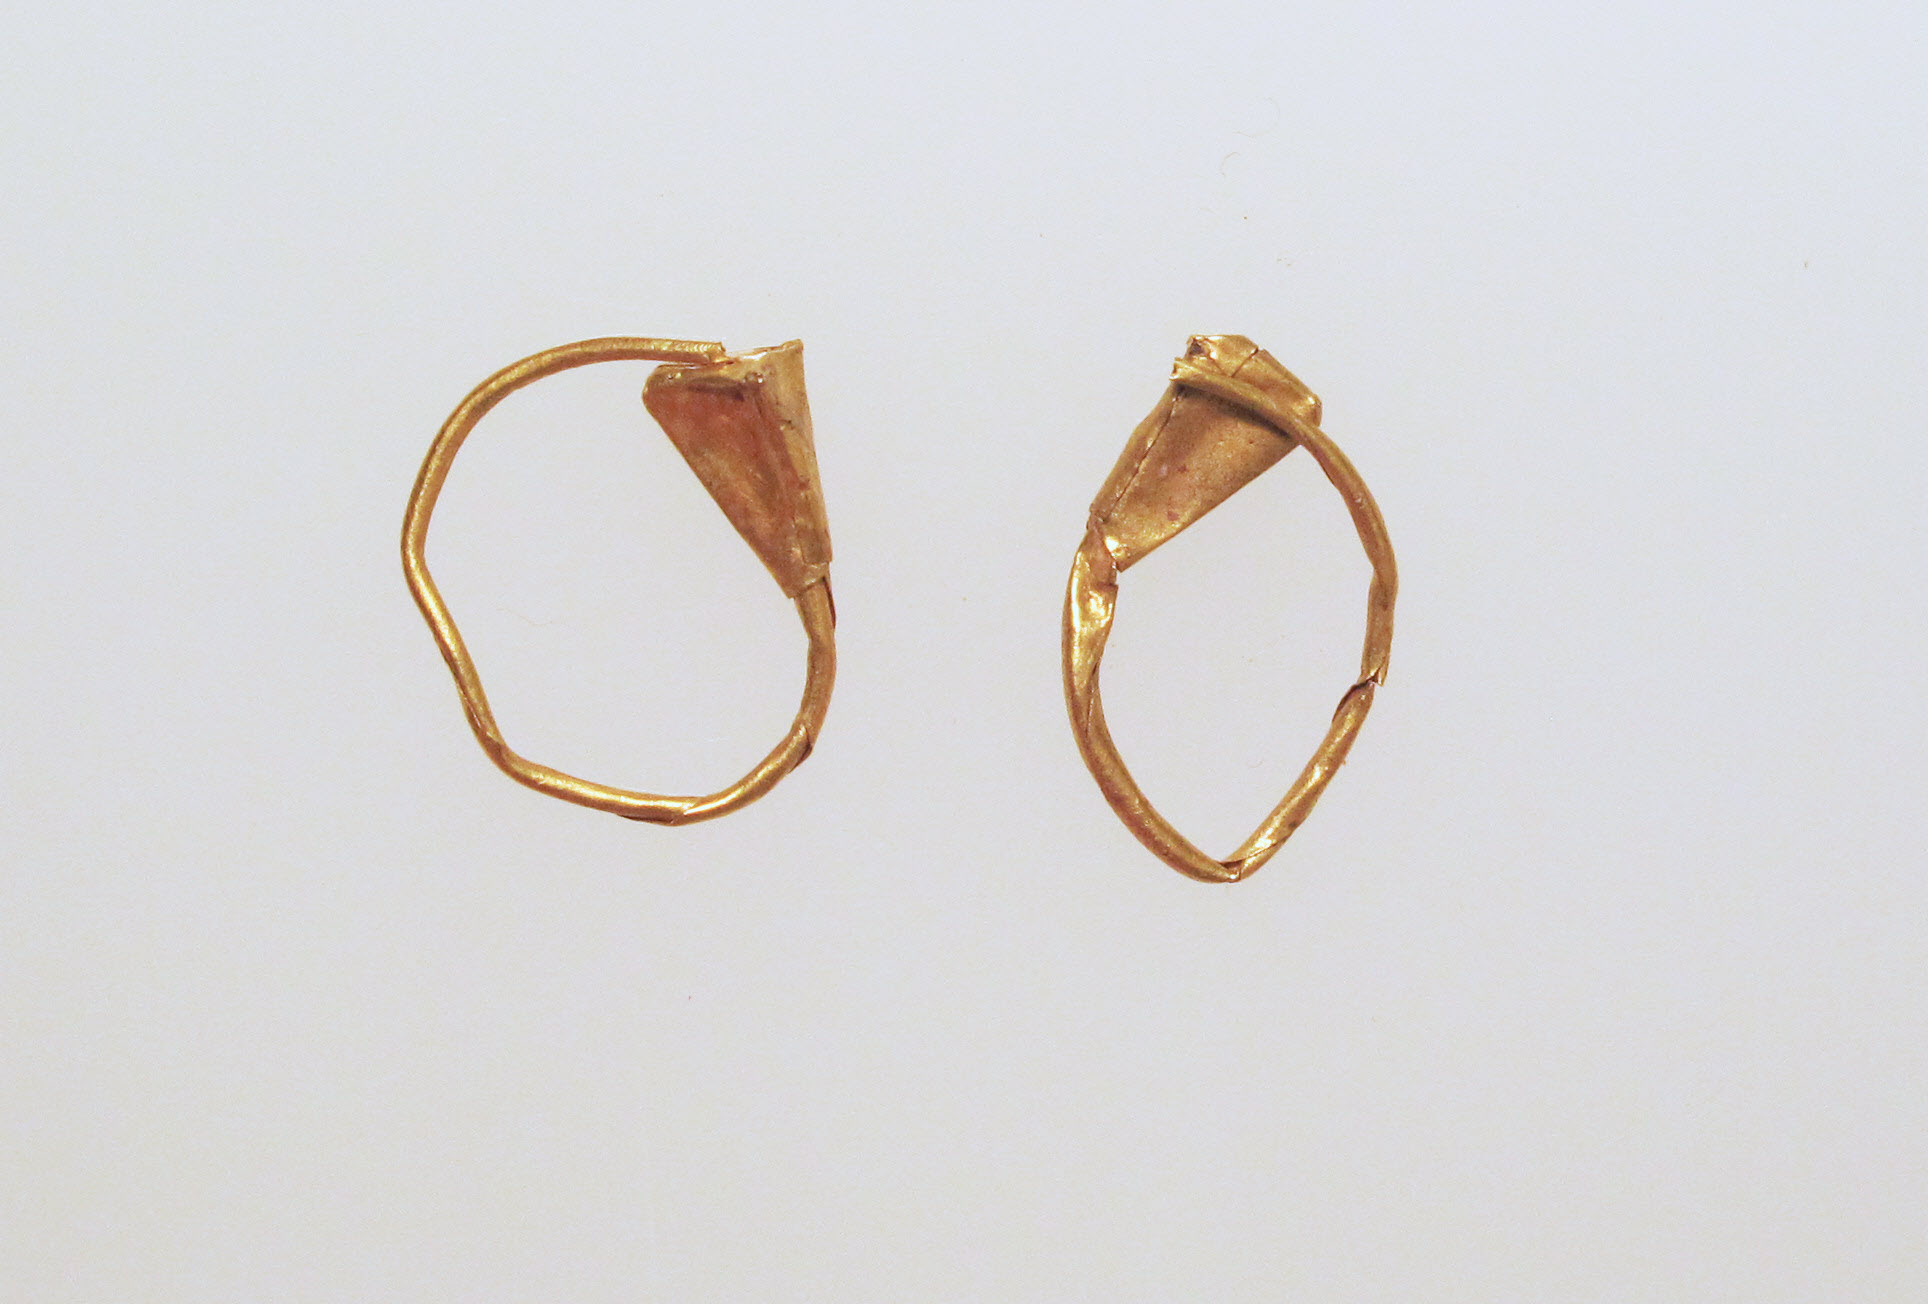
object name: earring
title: Earrings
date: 7000 BCE-330 CE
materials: gold